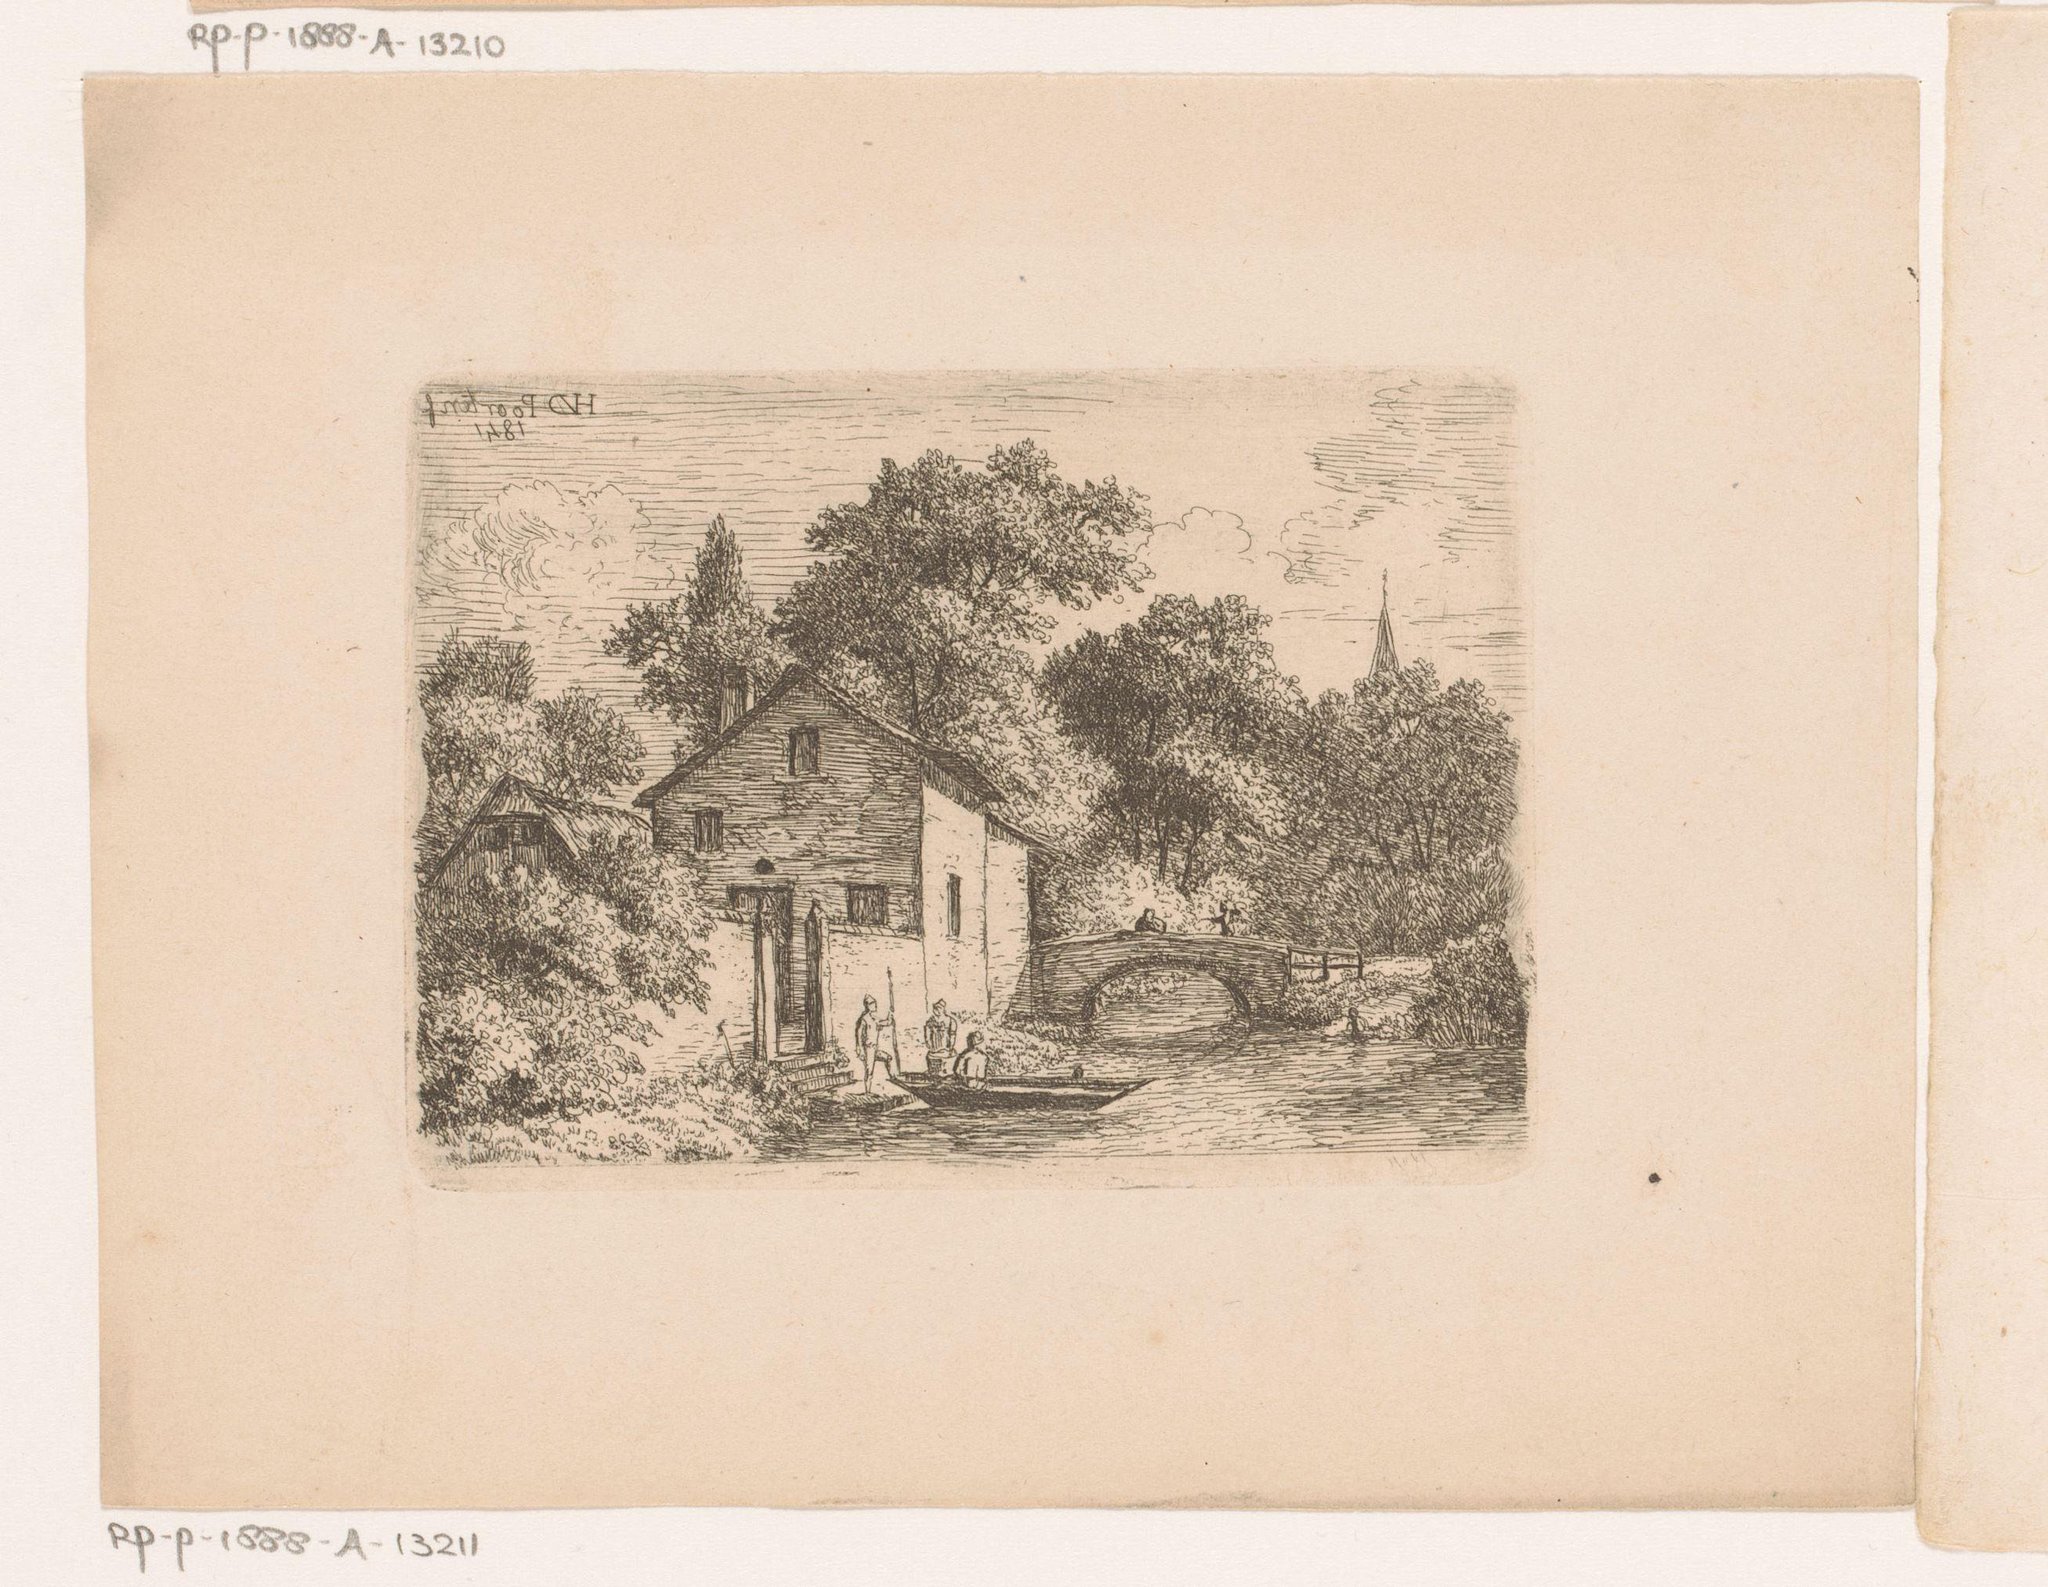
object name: print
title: Drie figuren bij een roeiboot voor een gebouw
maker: hendrik jozef franciscus van der poorten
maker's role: draughtsman, print maker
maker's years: 1789-1874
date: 1841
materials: paper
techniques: drypoint, etching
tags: rowing-boat, canoe, etc., bridge in village across river, canal, etc.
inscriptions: collector's mark: Lugt 2228